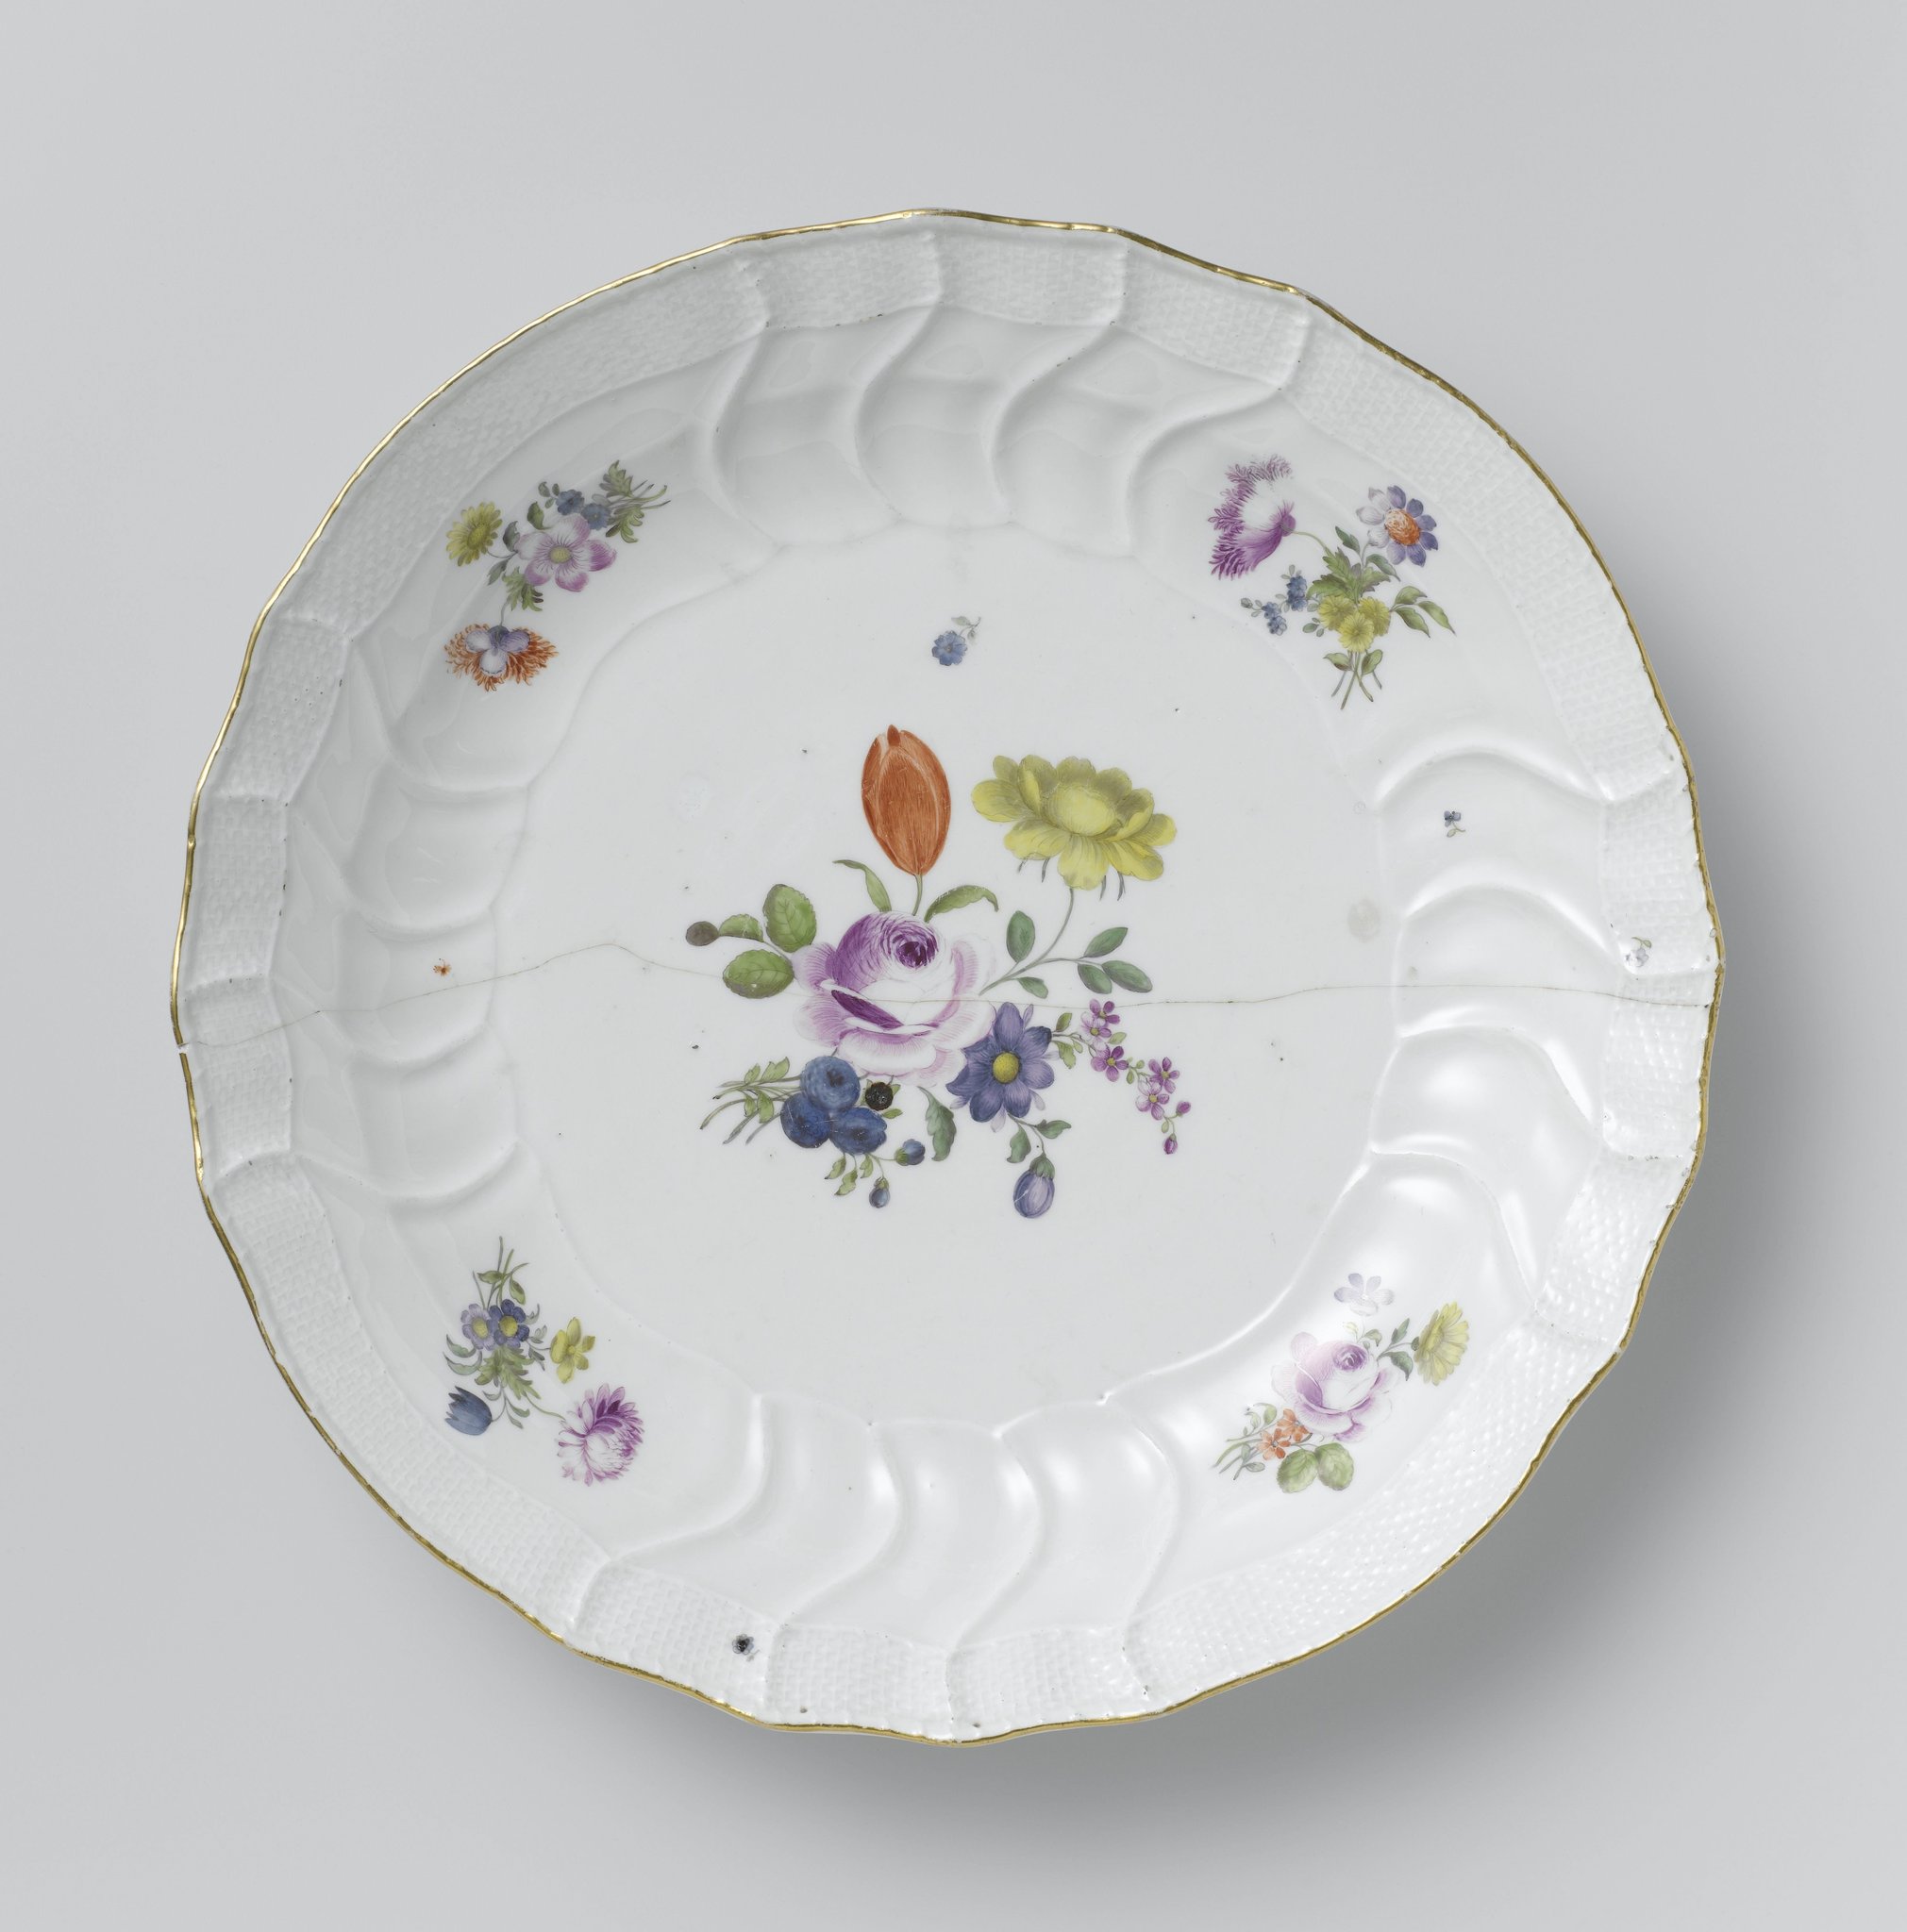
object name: platter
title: Schotel, veelkleurig beschilderd met Deutsche Blumen, insekten en vruchten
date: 1750-1760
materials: porcelain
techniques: painted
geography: meissen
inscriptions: factory mark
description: Ronde schotel van beschilderd porselein. De schotel is beschilderd met Deutsche Blumen, insekten en vruchten. De rand is in reliëf versierd met het Neuozier-patroon. De schotel is gemerkt en hoort bij een servies (BK-17474-1 t/m BK-17474-253).